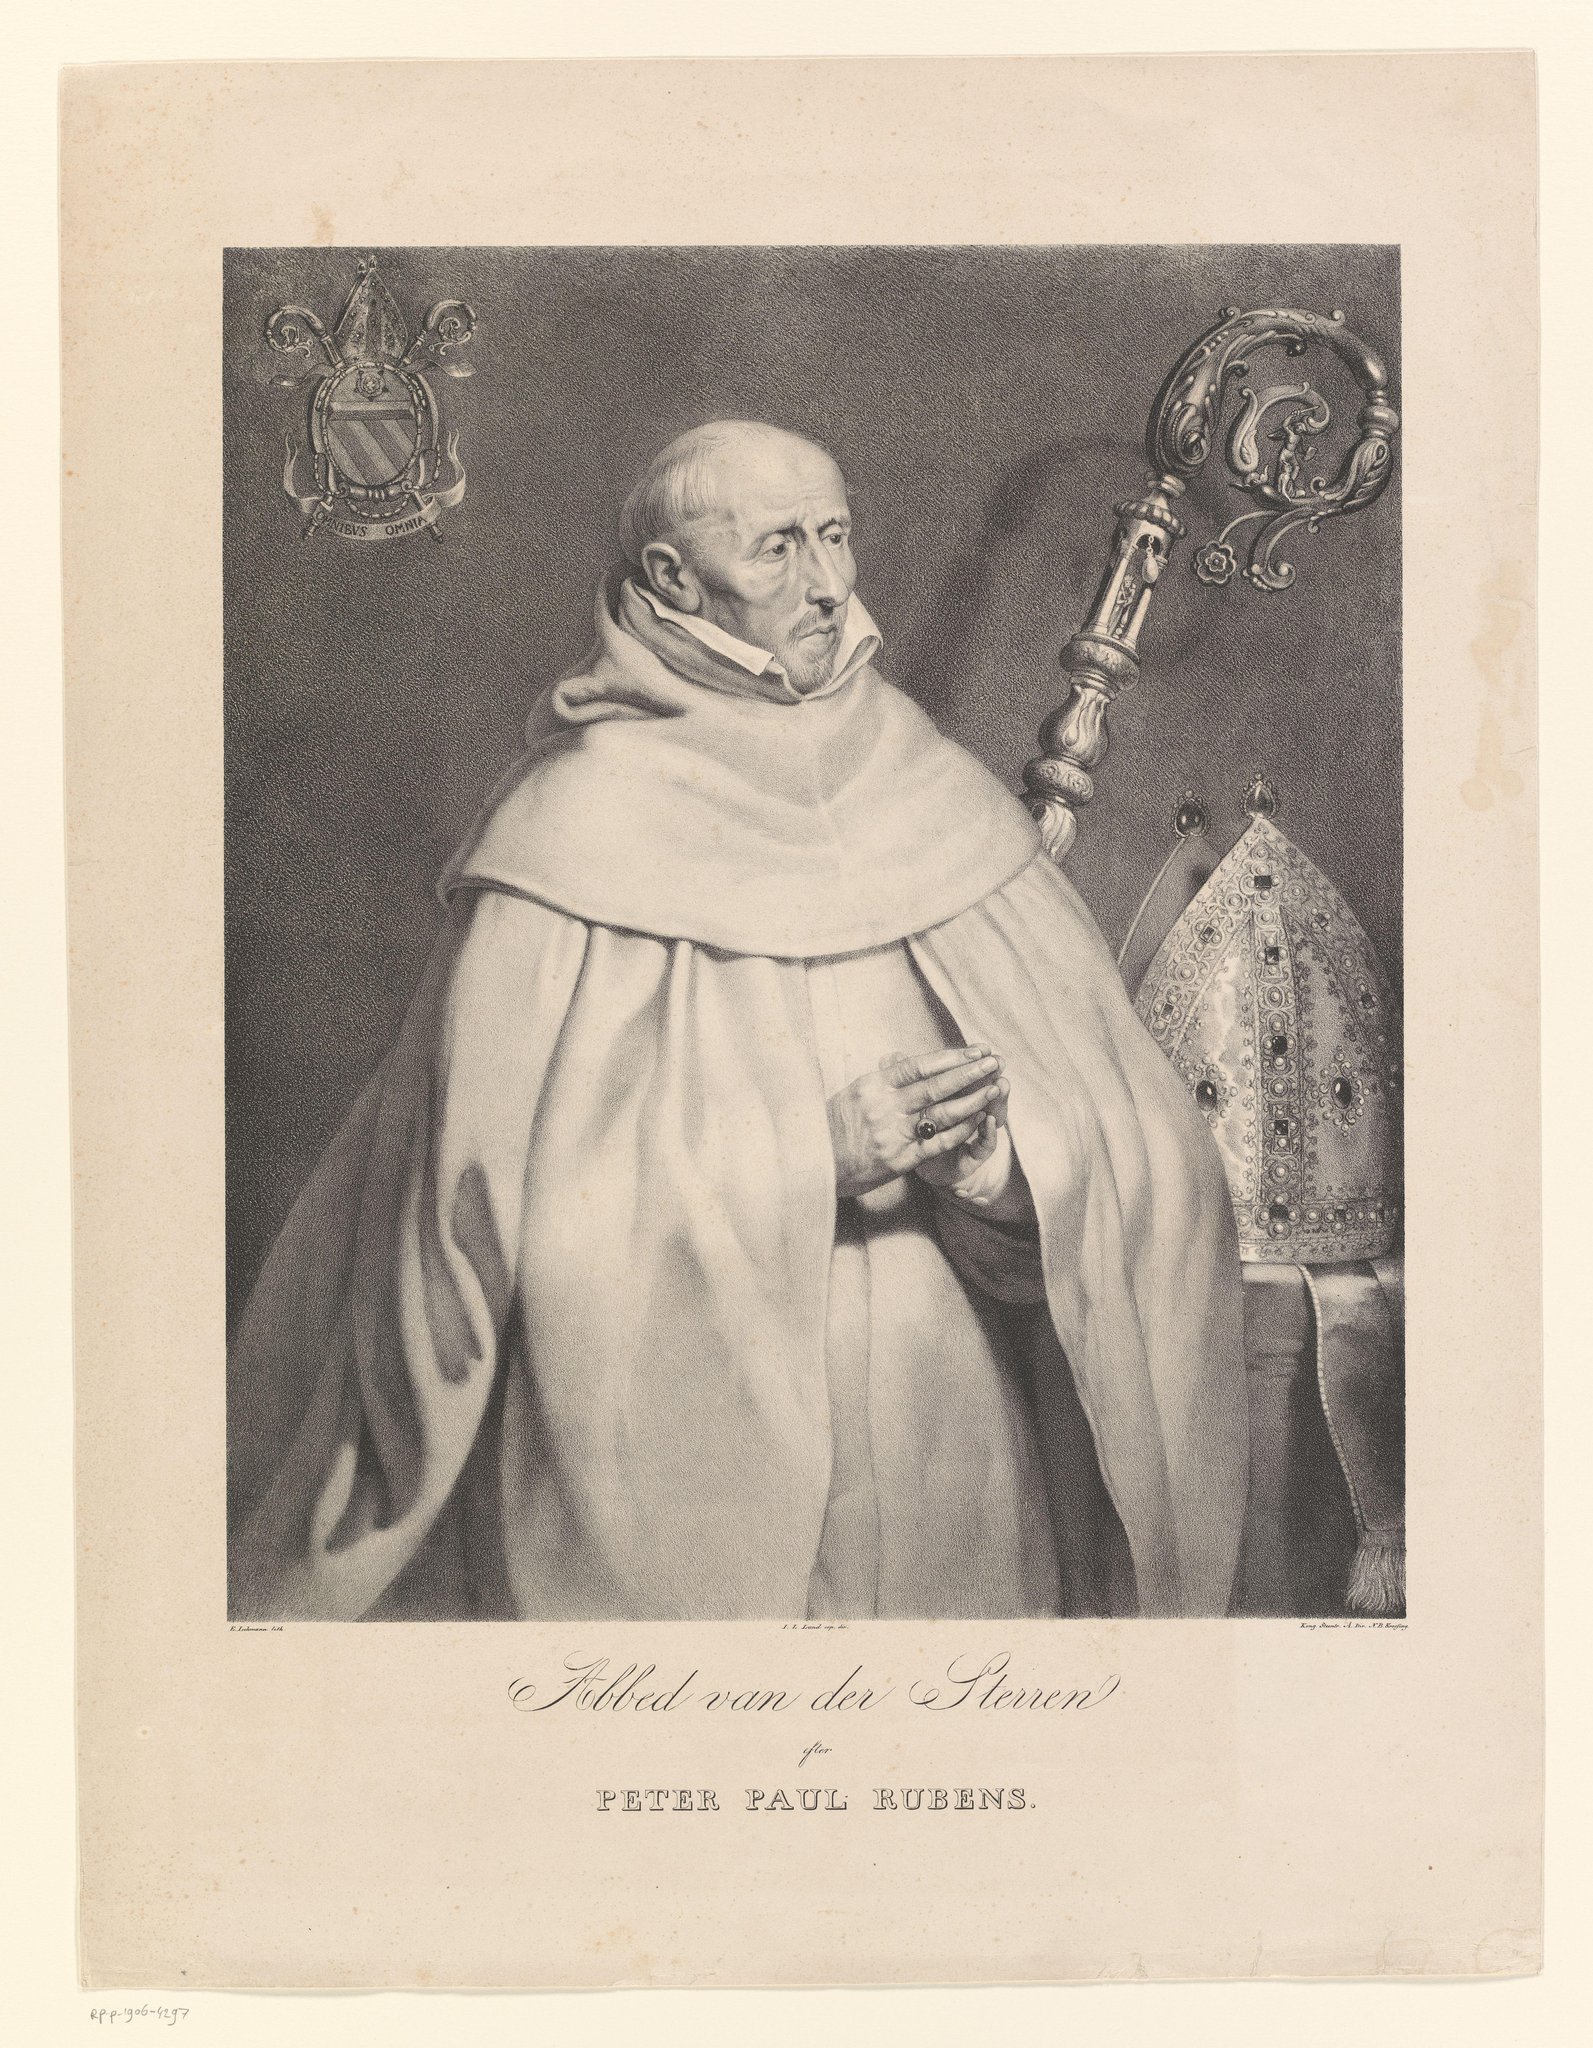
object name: print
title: Portret van Matthaeus Yrsselius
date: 1825-1892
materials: paper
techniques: lithograph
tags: abbot, adult man, historical persons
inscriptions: collector's mark: Lugt 2228